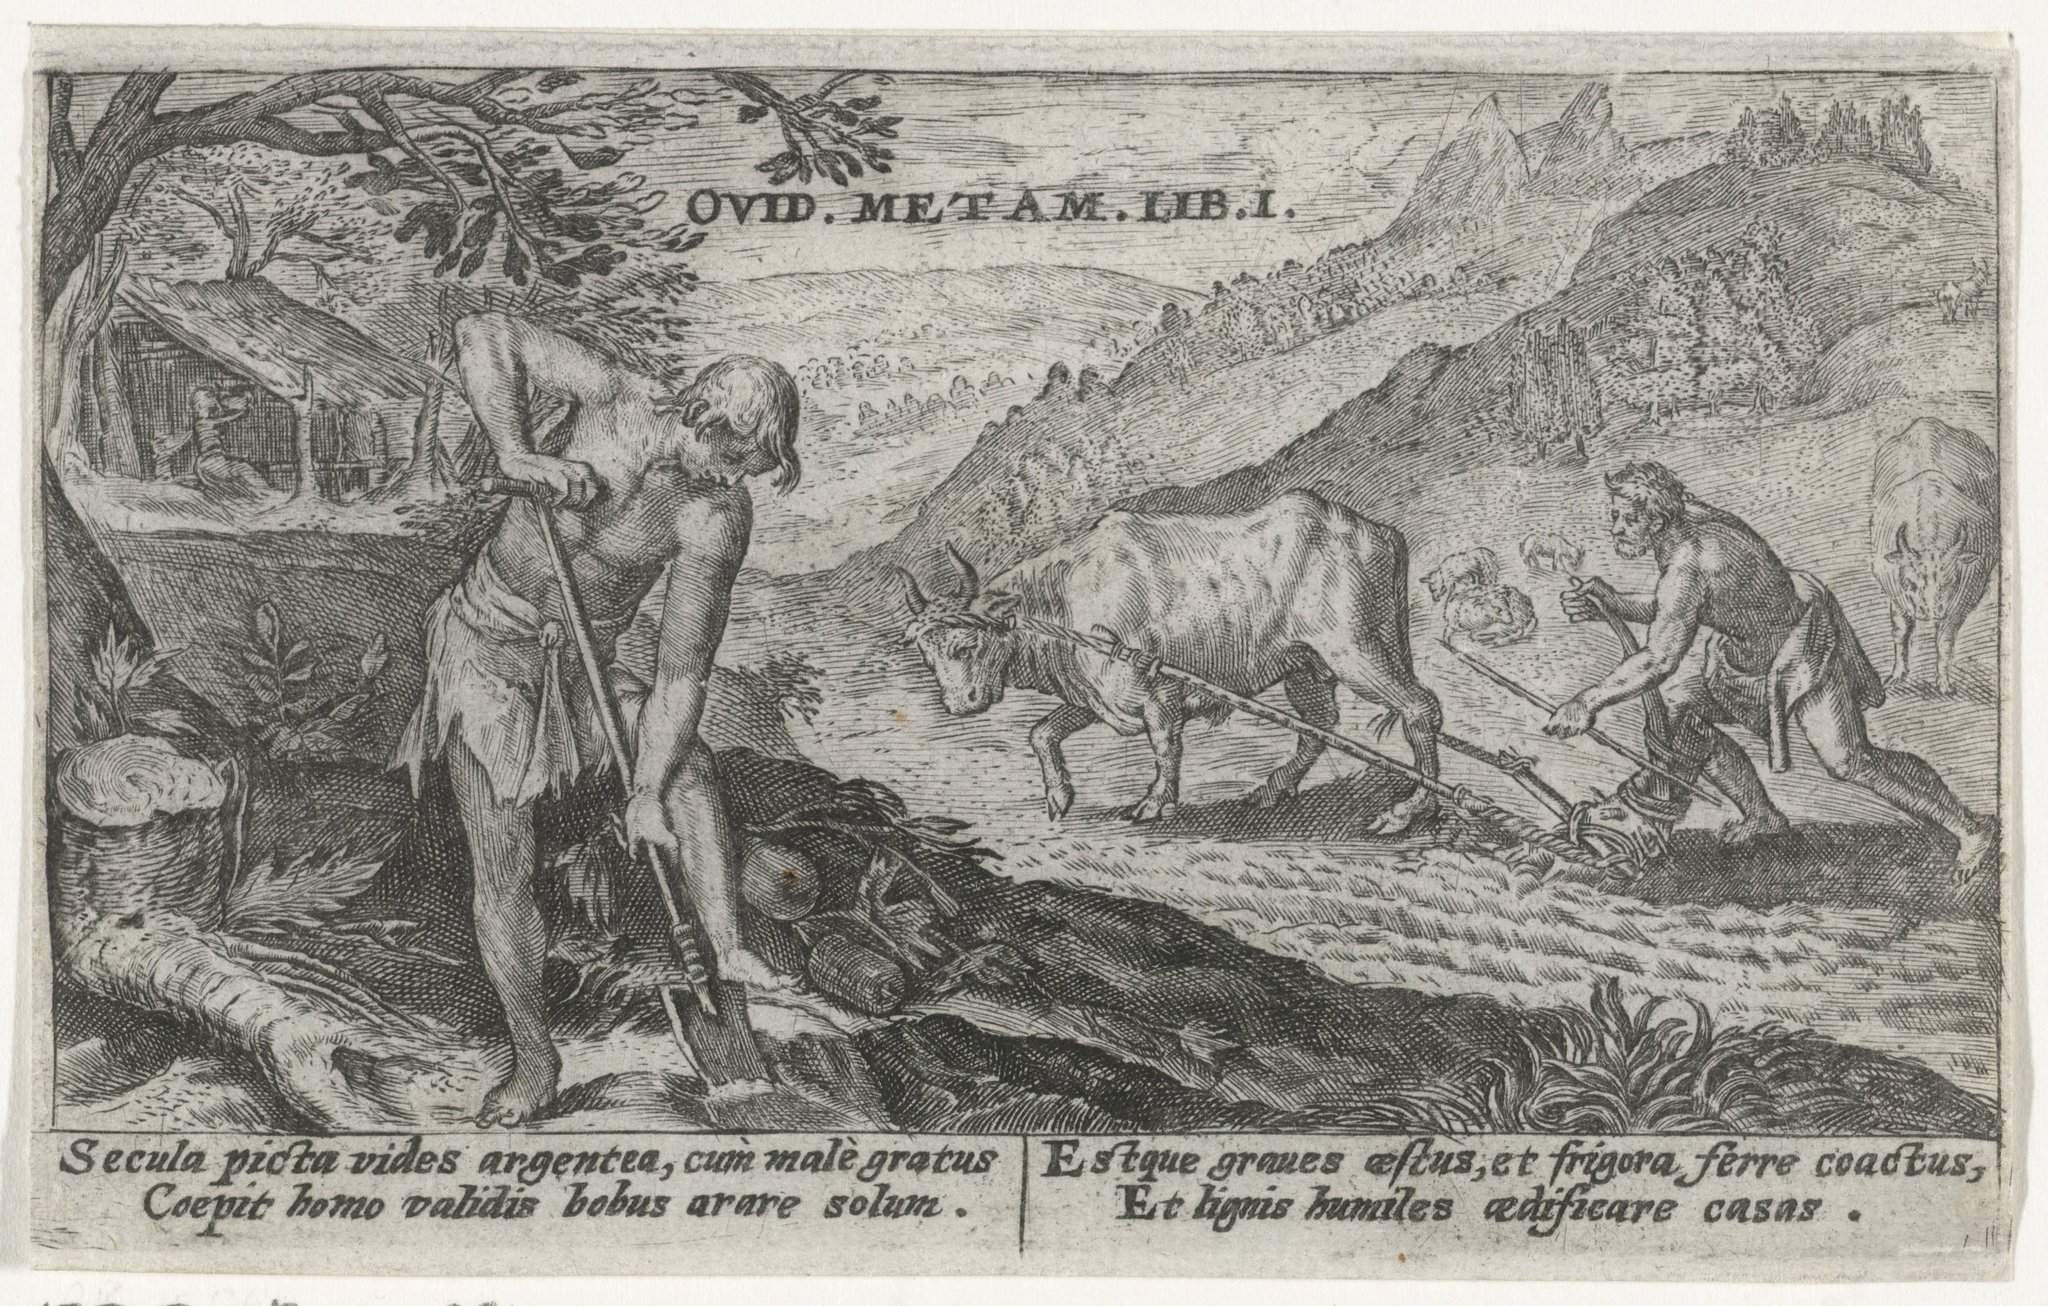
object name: print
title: Het Zilveren tijdperk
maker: crispijn van de passe (i)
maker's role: draughtsman, print maker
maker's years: 1564-1637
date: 1602-1607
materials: paper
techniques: engraving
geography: cologne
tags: the silver age, 'aetas argentea'; men plough the soil and build huts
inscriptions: collector's mark: Lugt 2228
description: Het Zilveren tijdperk: de mens moet rekening houden met de seizoenen. Boeren ploegen en zaaien. Op de achtergrond een primitief onderkomen dat bescherming biedt tegen kou. In de marge een vierregelig onderschrift, in twee kolommen, in het Latijn.